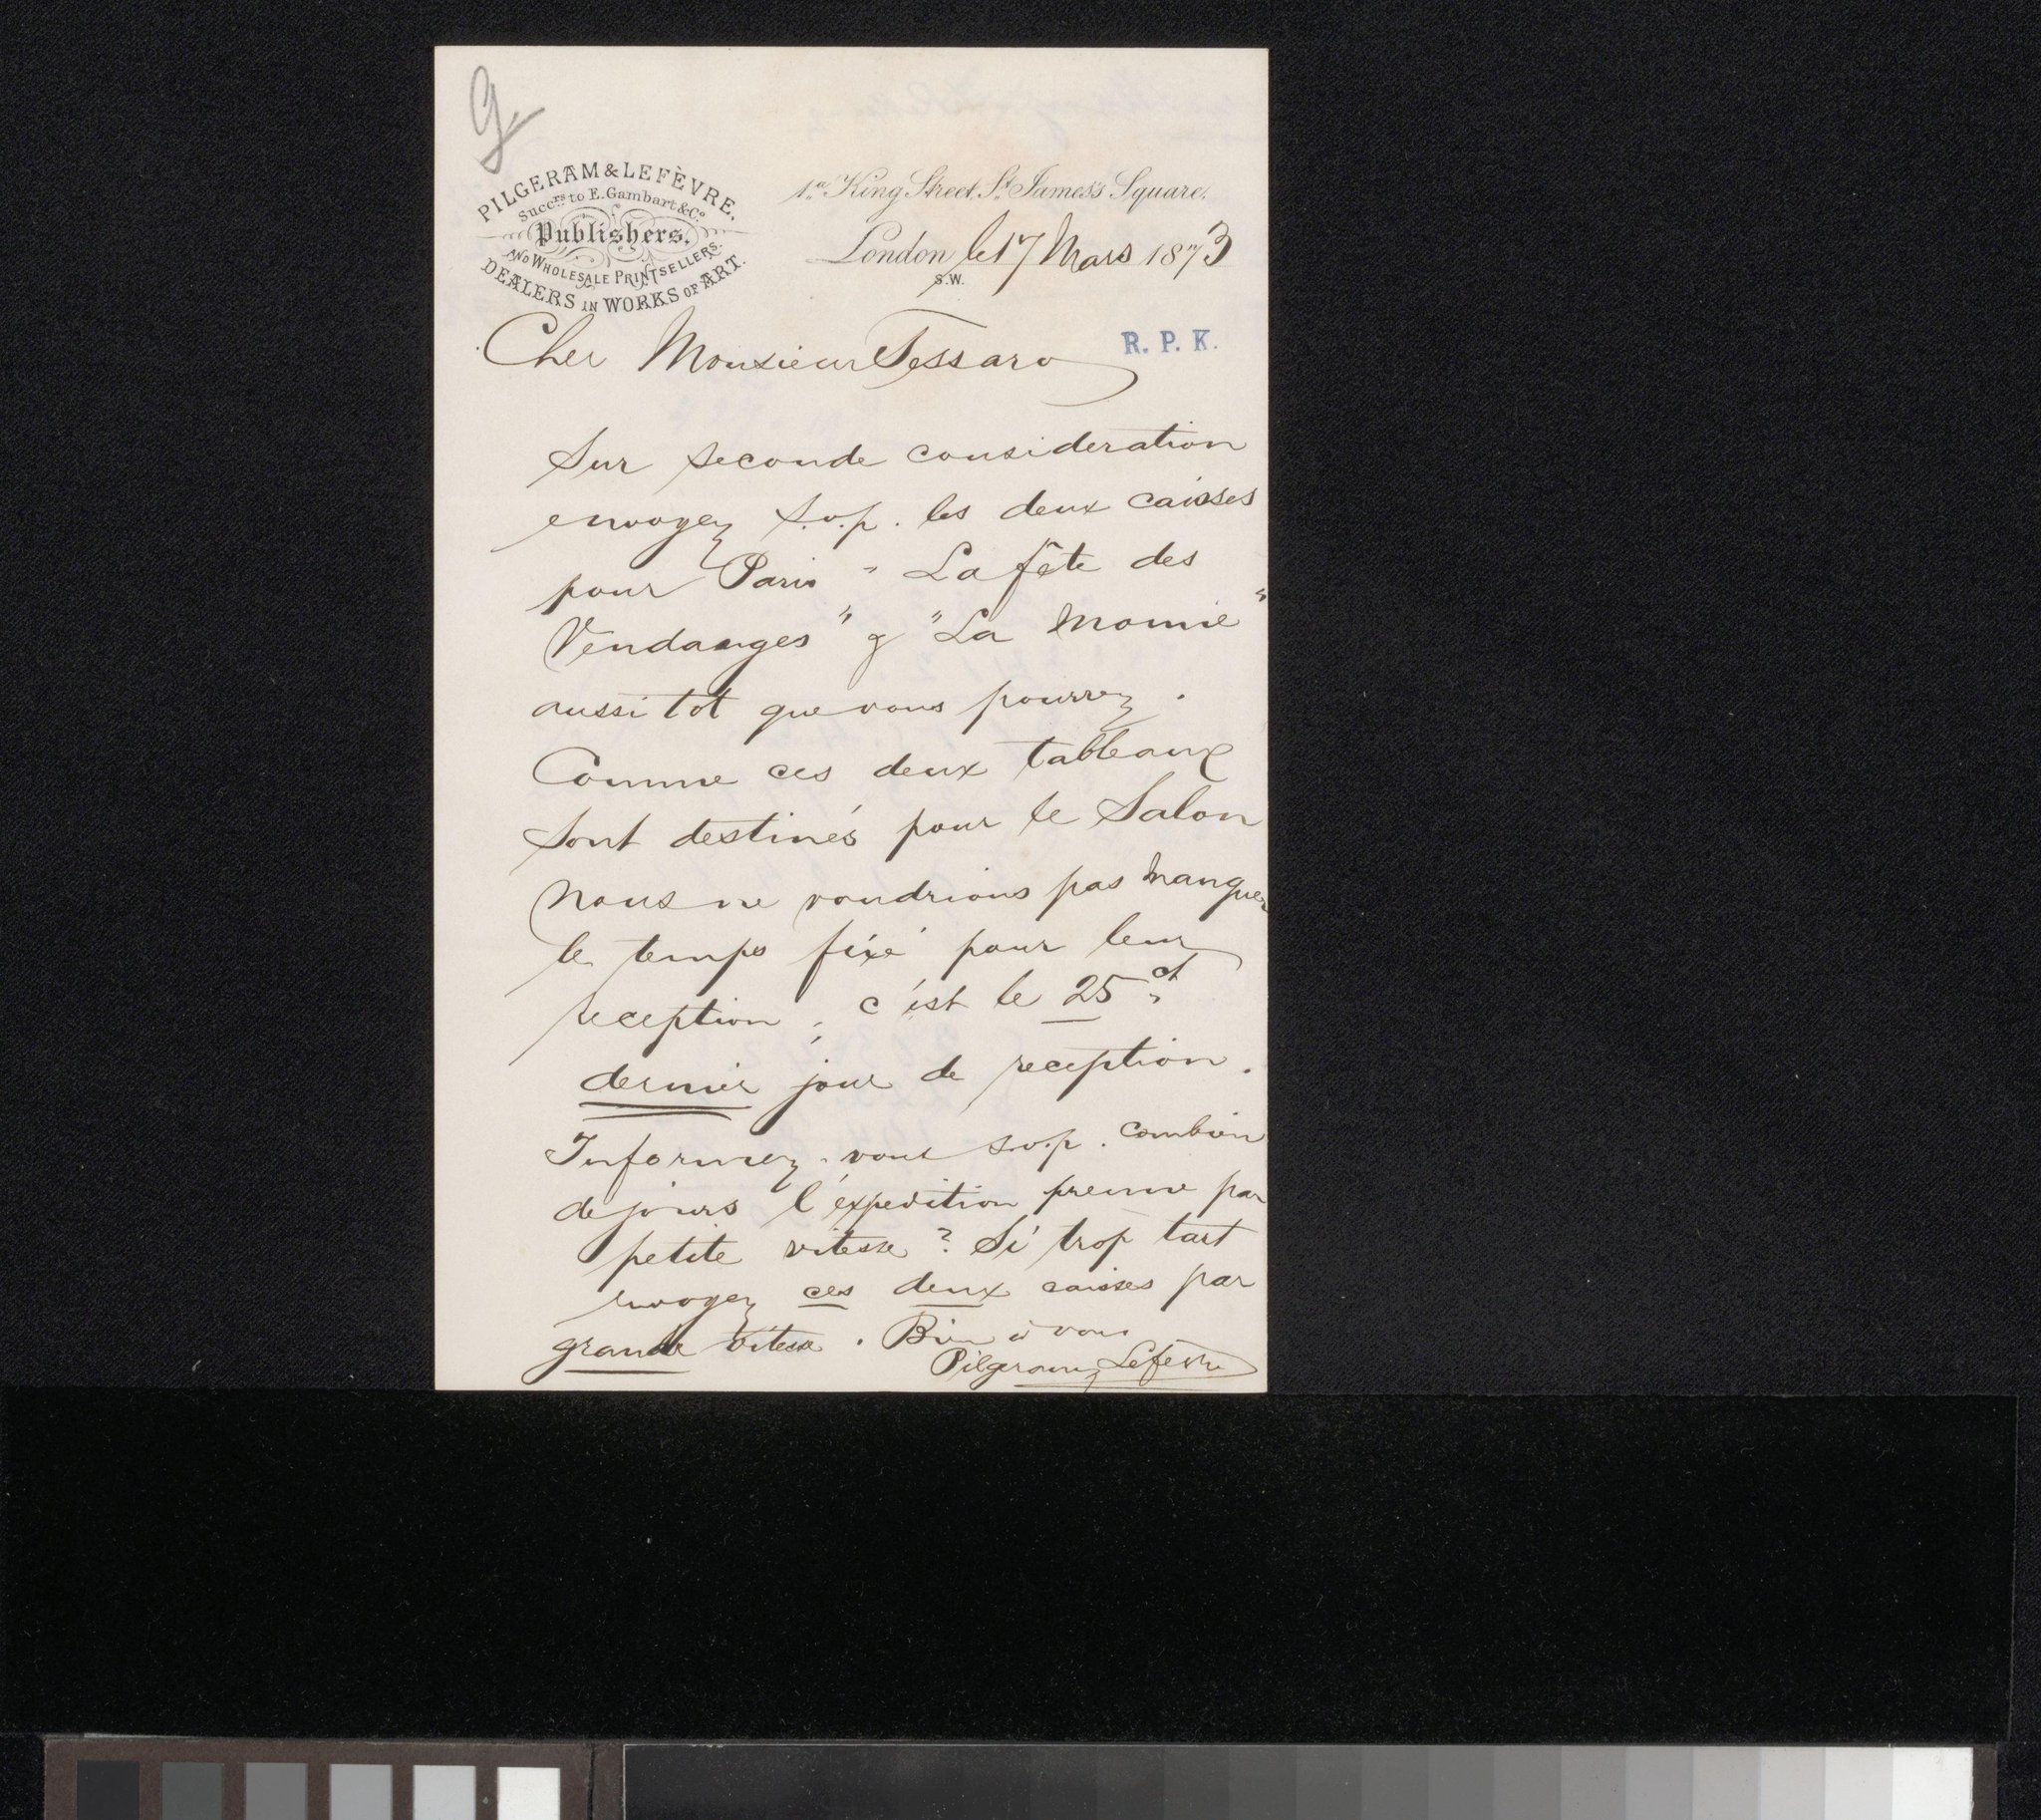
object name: letter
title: Brief aan Filippo Tessaro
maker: Anonymous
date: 1873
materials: ink, paper, pencil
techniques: pen, printing, writing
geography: london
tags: amsterdam, the hague, painter, print maker, draughtsman, jozef israëls, painting (including book-illumination, miniature-painting), exhibition ~ art, paris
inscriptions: collector's mark: Lugt 2233, watermark